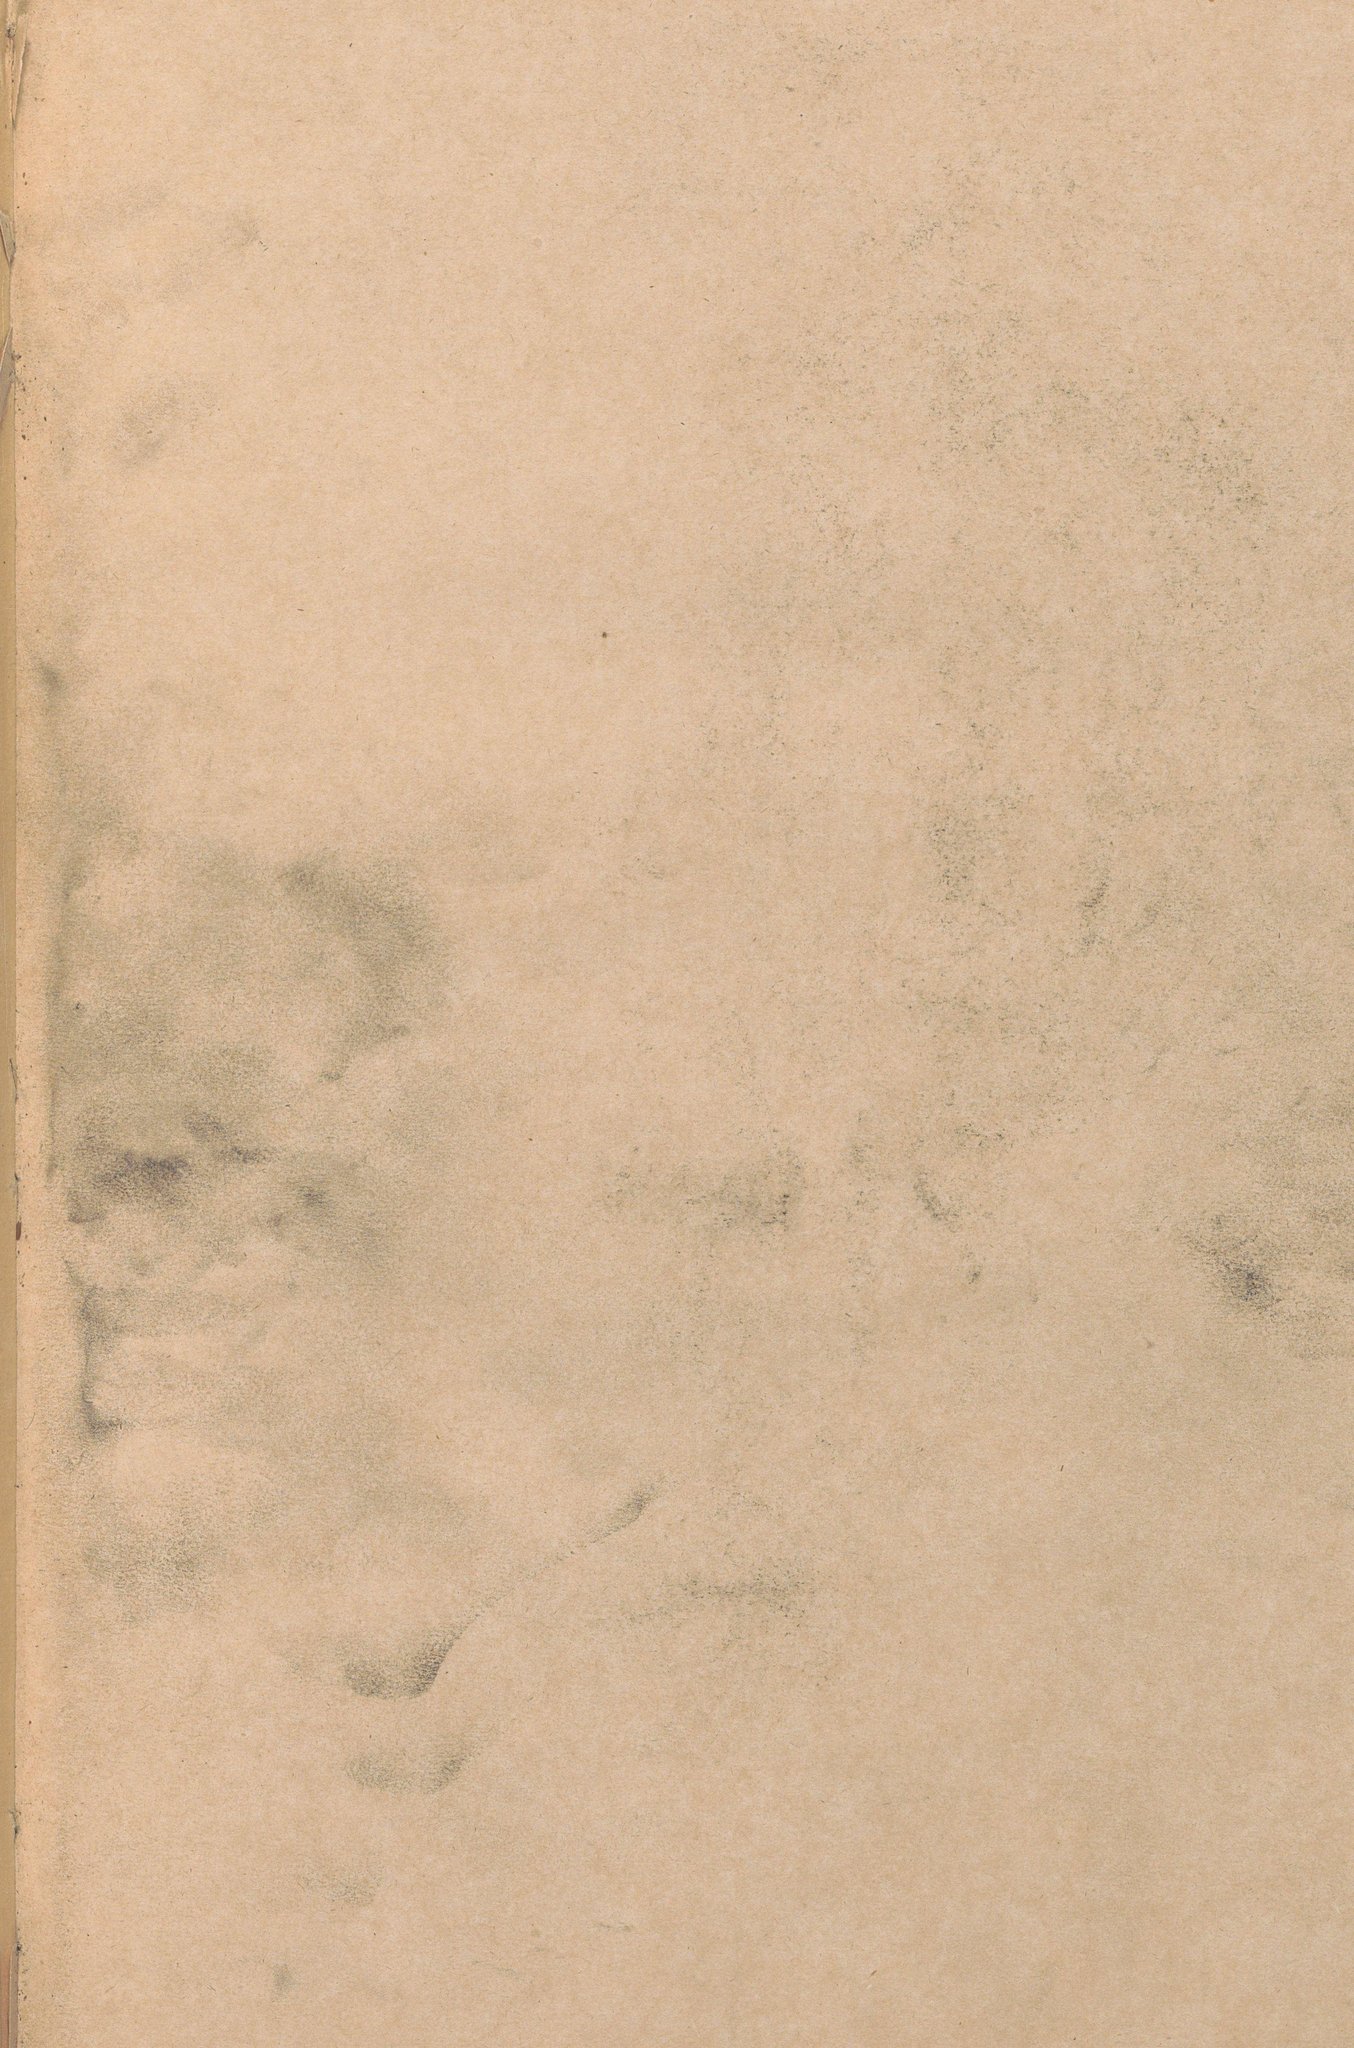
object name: sketchbook leaf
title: Abklatsch van een krijttekening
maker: willem witsen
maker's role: draughtsman, painter, print maker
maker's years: 1860-1923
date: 1884-1887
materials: paper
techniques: printmaking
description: Pagina 43 uit een schetsboek met 44 bladen.